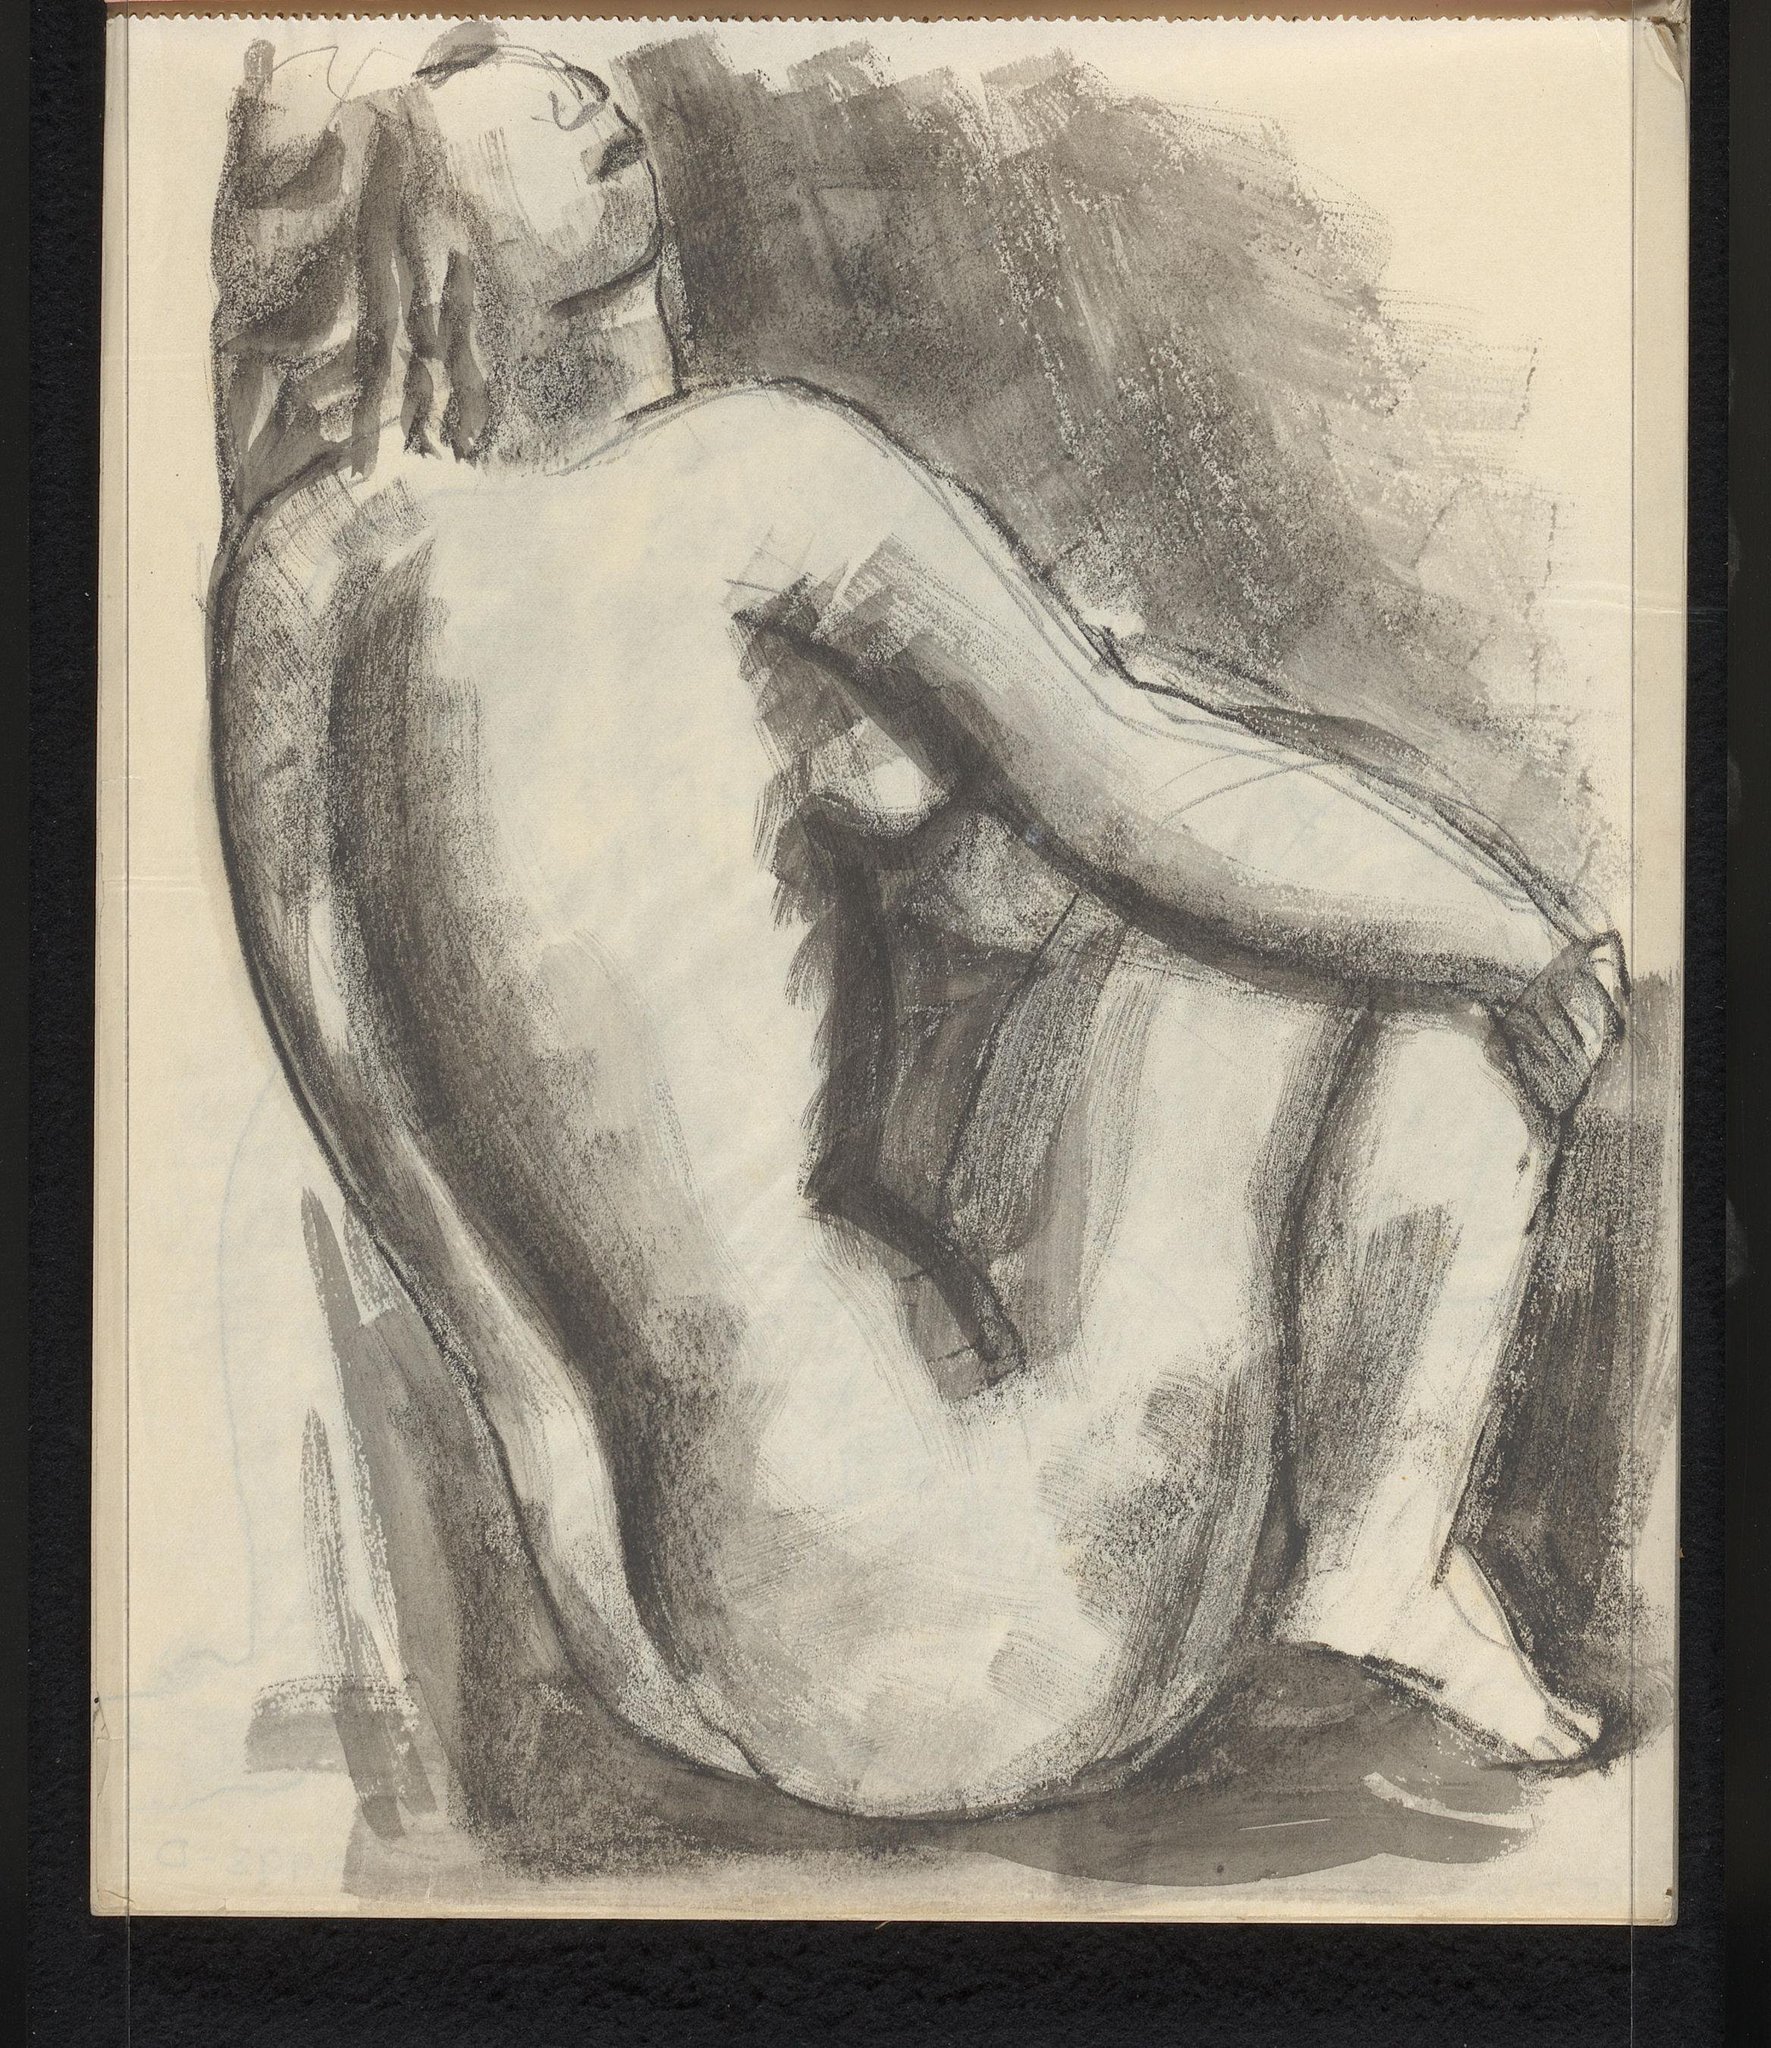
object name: drawing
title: Vrouwelijk naakt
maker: leo gestel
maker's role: draughtsman, print maker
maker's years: 1881-1941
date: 1934-1936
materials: chalk, ink, paper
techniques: brush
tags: woman (showing herself) undressed, quasi-nude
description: Zittend vrouwelijk naakt; onderdeel van een schetsboek.